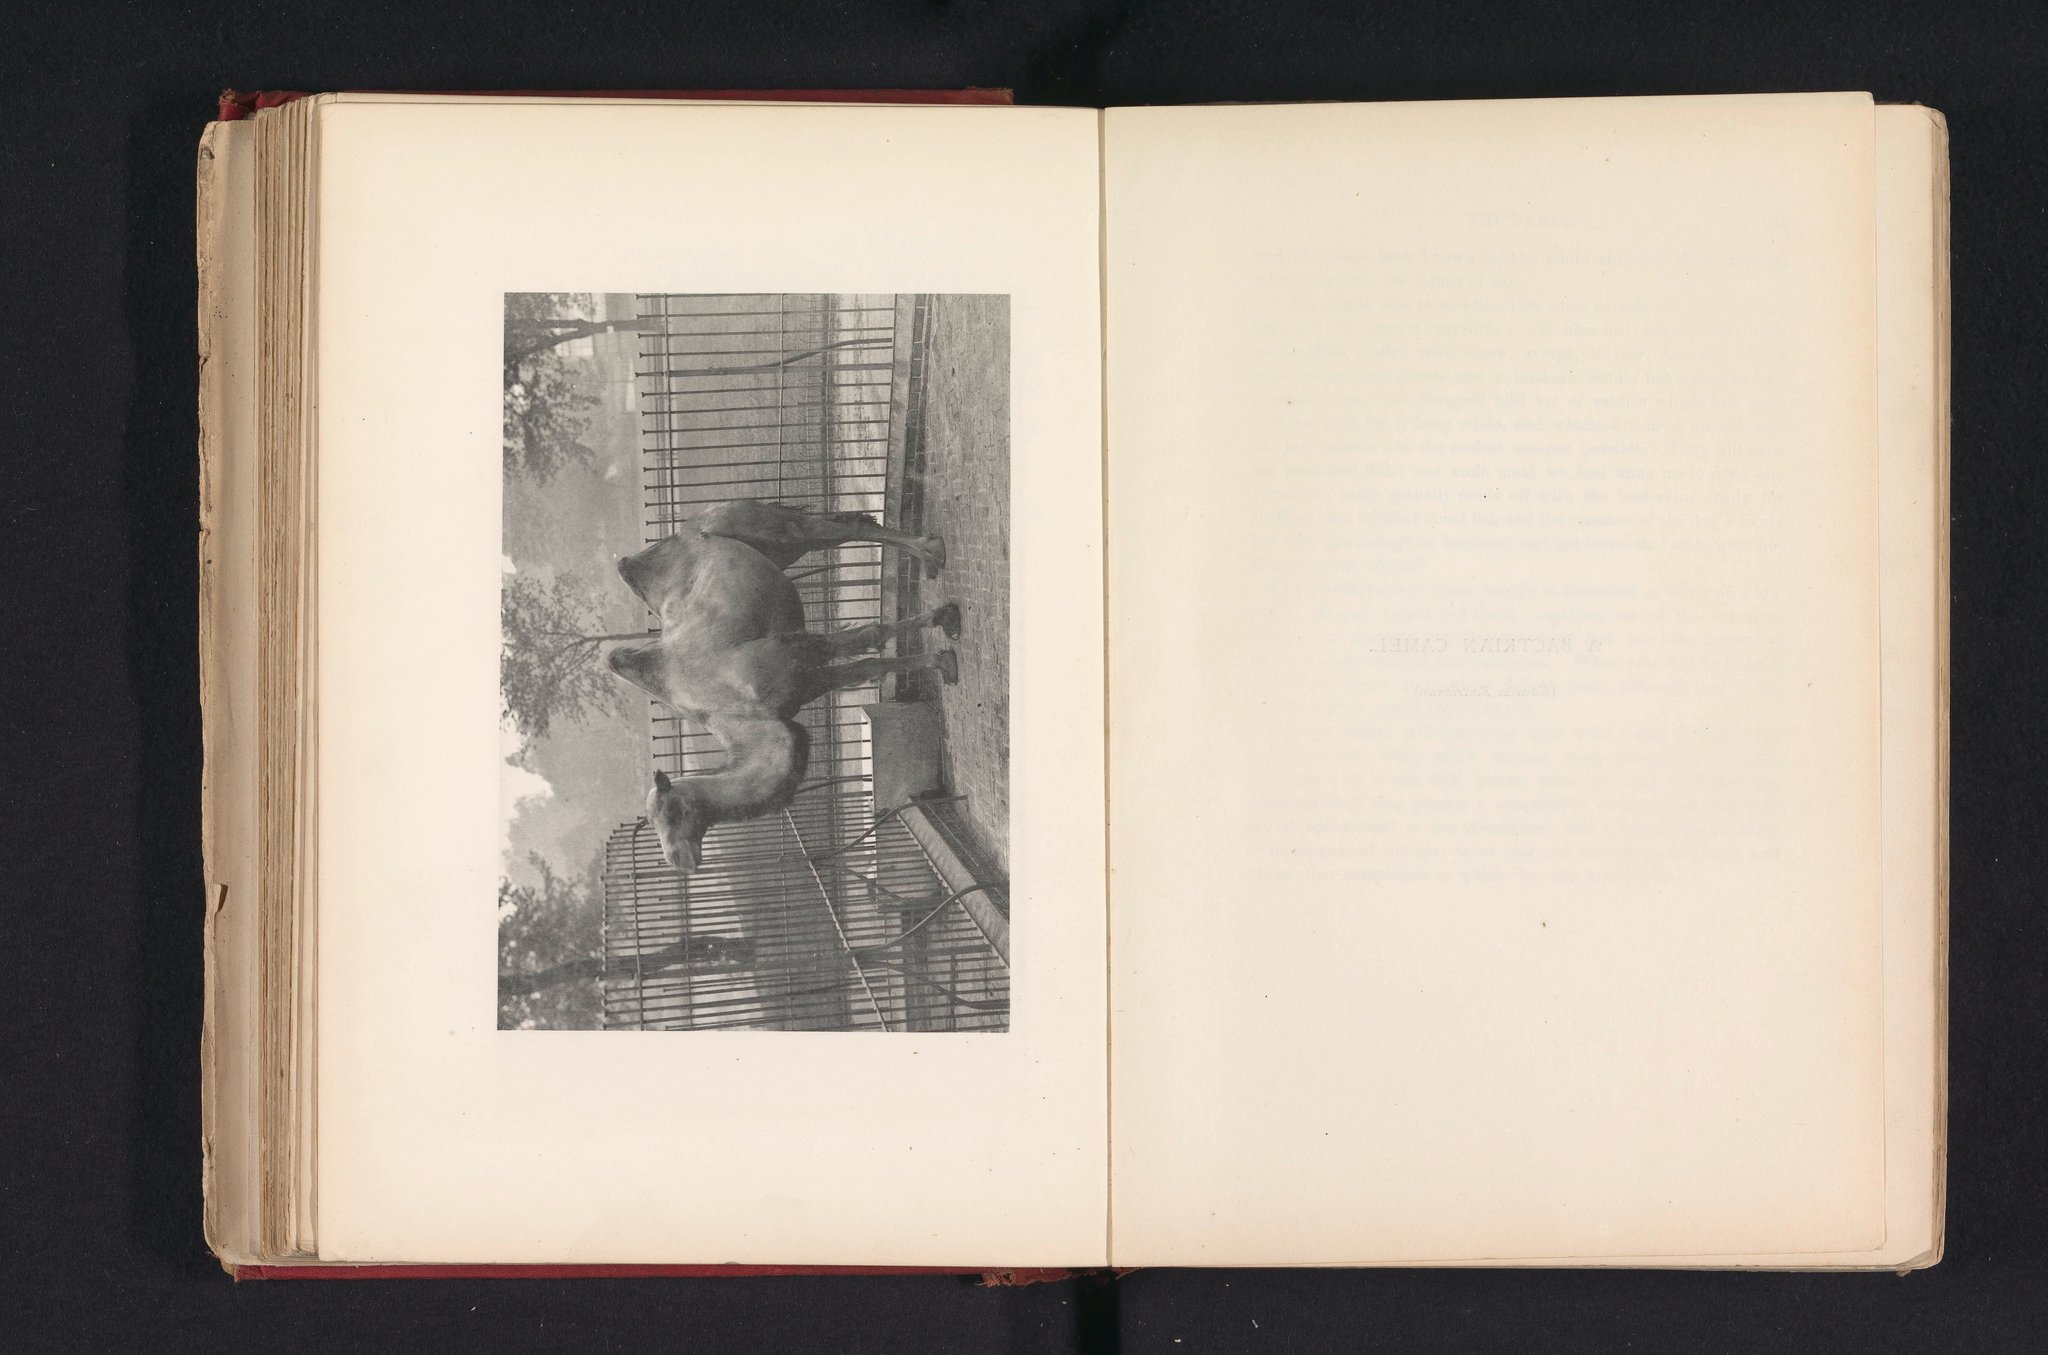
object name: page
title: A bactrian camel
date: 1876-1886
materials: paper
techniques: photograph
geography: paris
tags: hoofed animals: camel